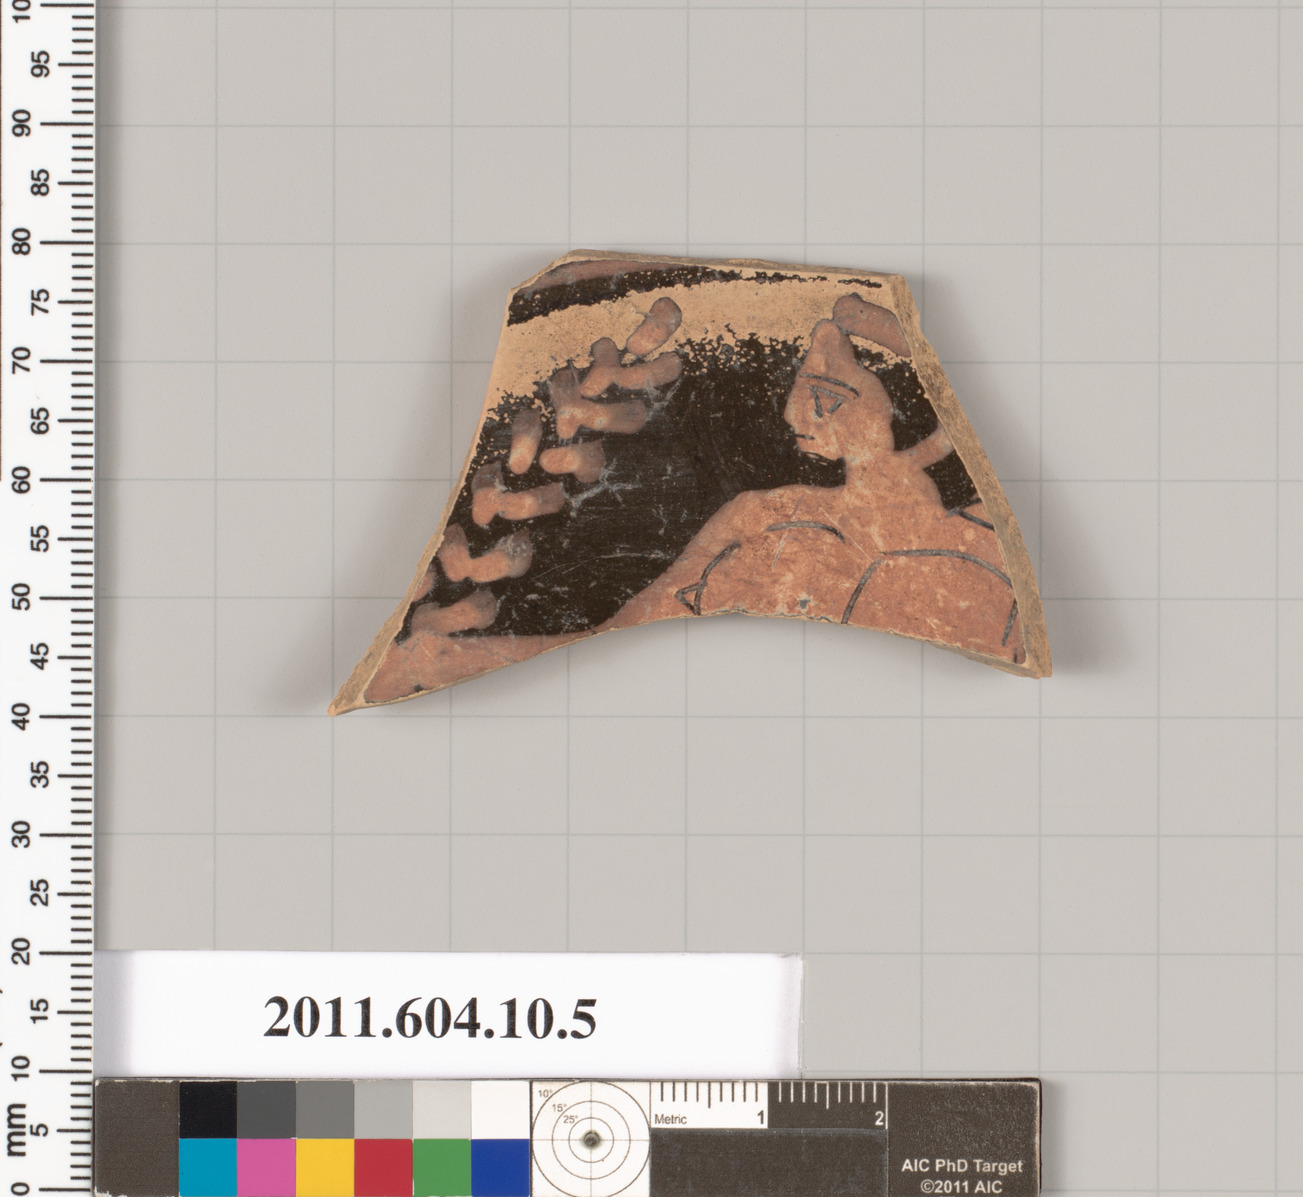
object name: kylix fragment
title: Terracotta fragment of a kylix (drinking cup)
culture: etruscan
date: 434-368 BCE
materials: terracotta